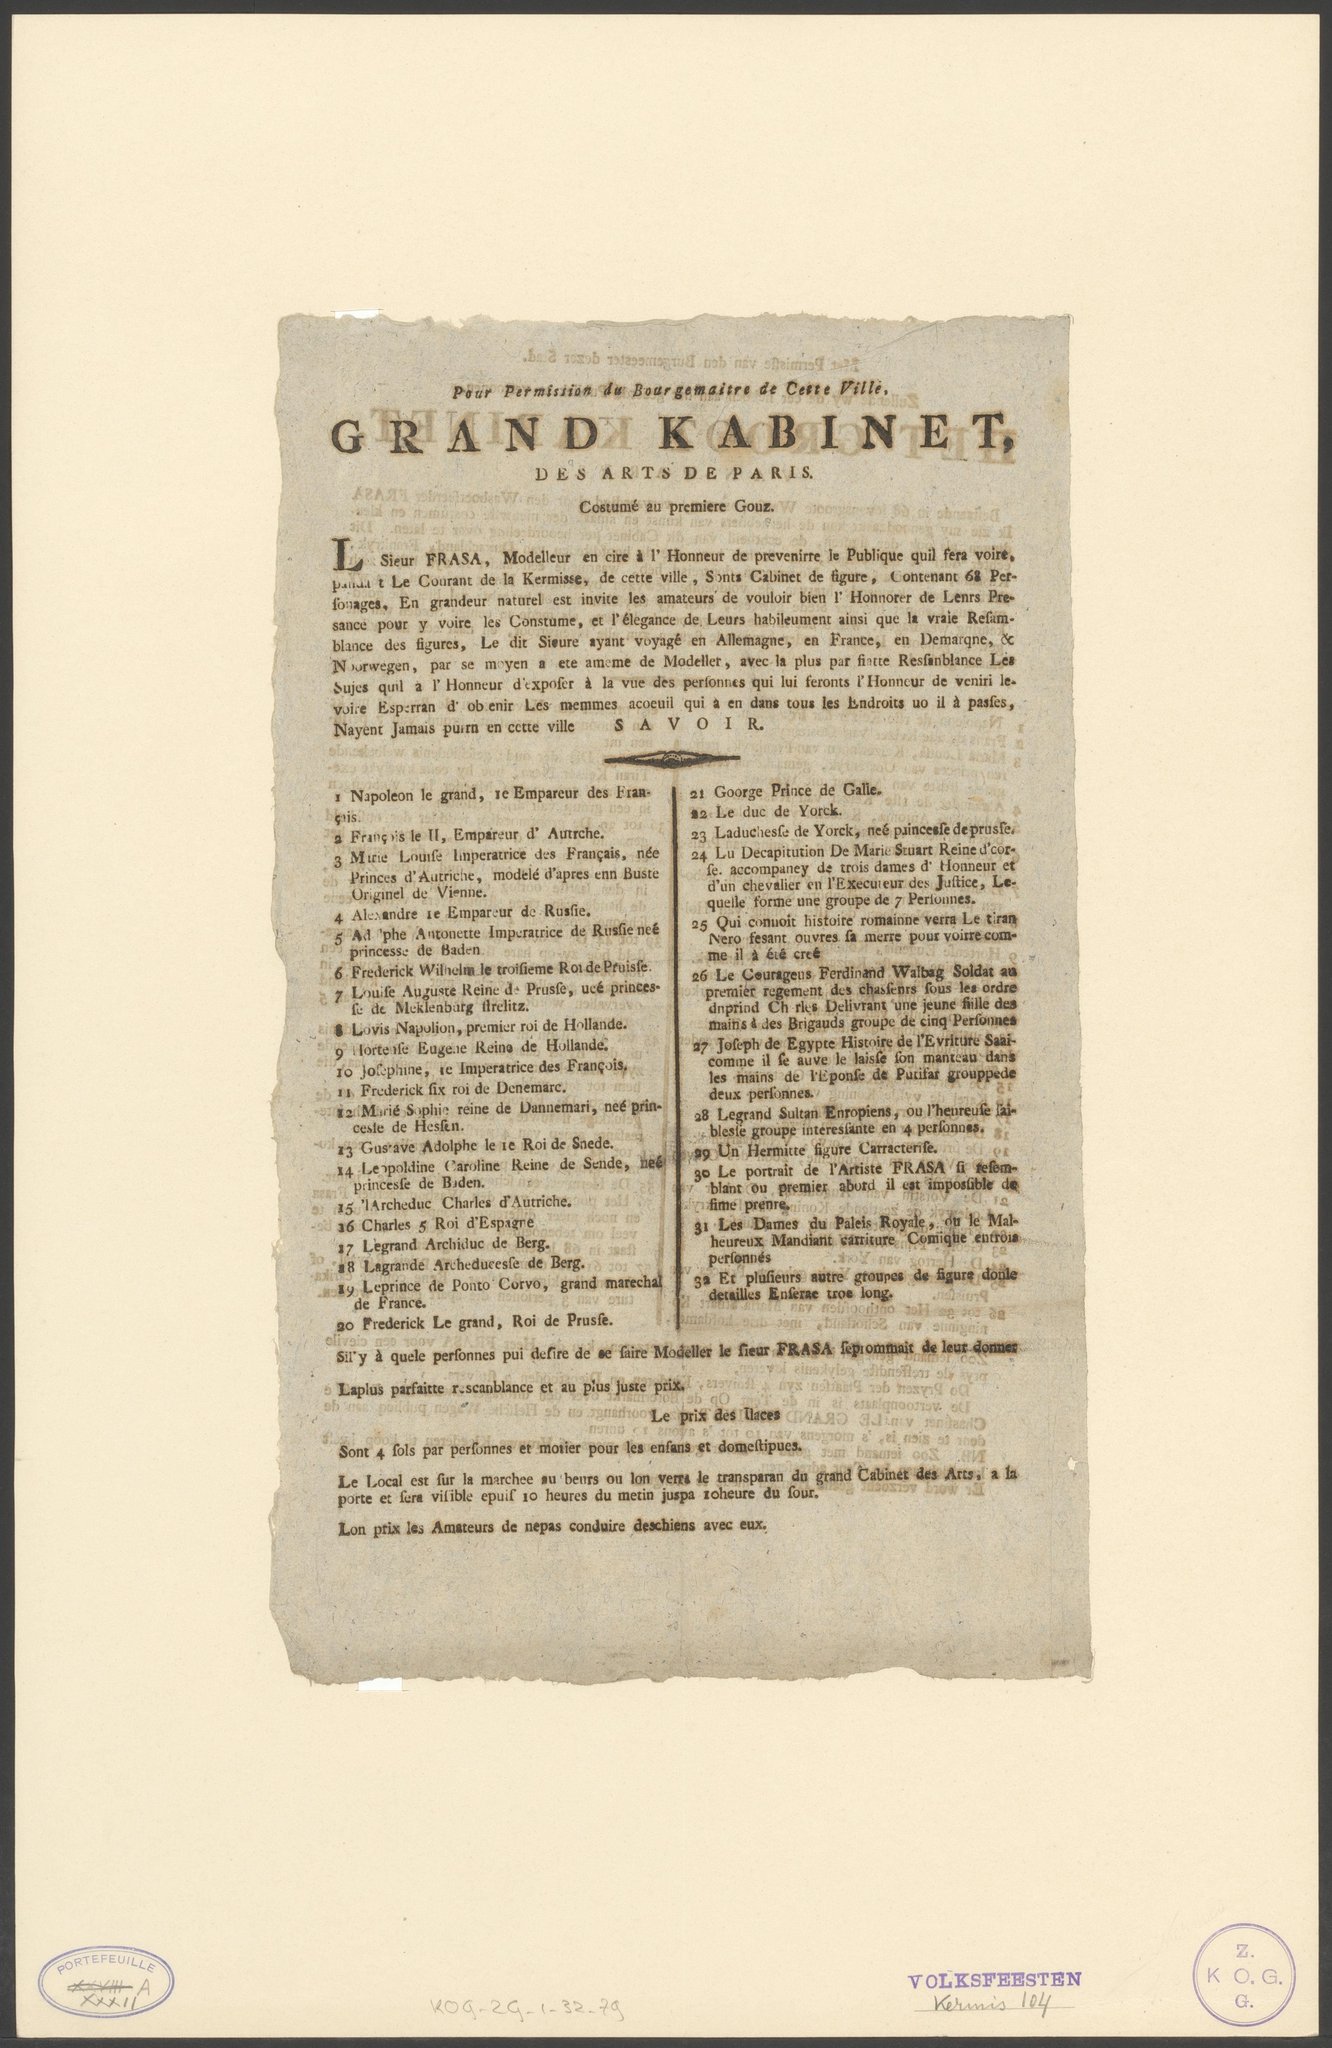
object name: reclamebiljet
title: Grand Kabinet, des Arts de Paris. Costumé au premiere Gouz / Het Groot Kabinet van Parys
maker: Anonymous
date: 1806-1815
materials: paper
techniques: letterpress printing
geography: netherlands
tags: wax-figure cabinet, pleasure fair and circus, amsterdam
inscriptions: collector's mark, collector's mark: Lugt 1641